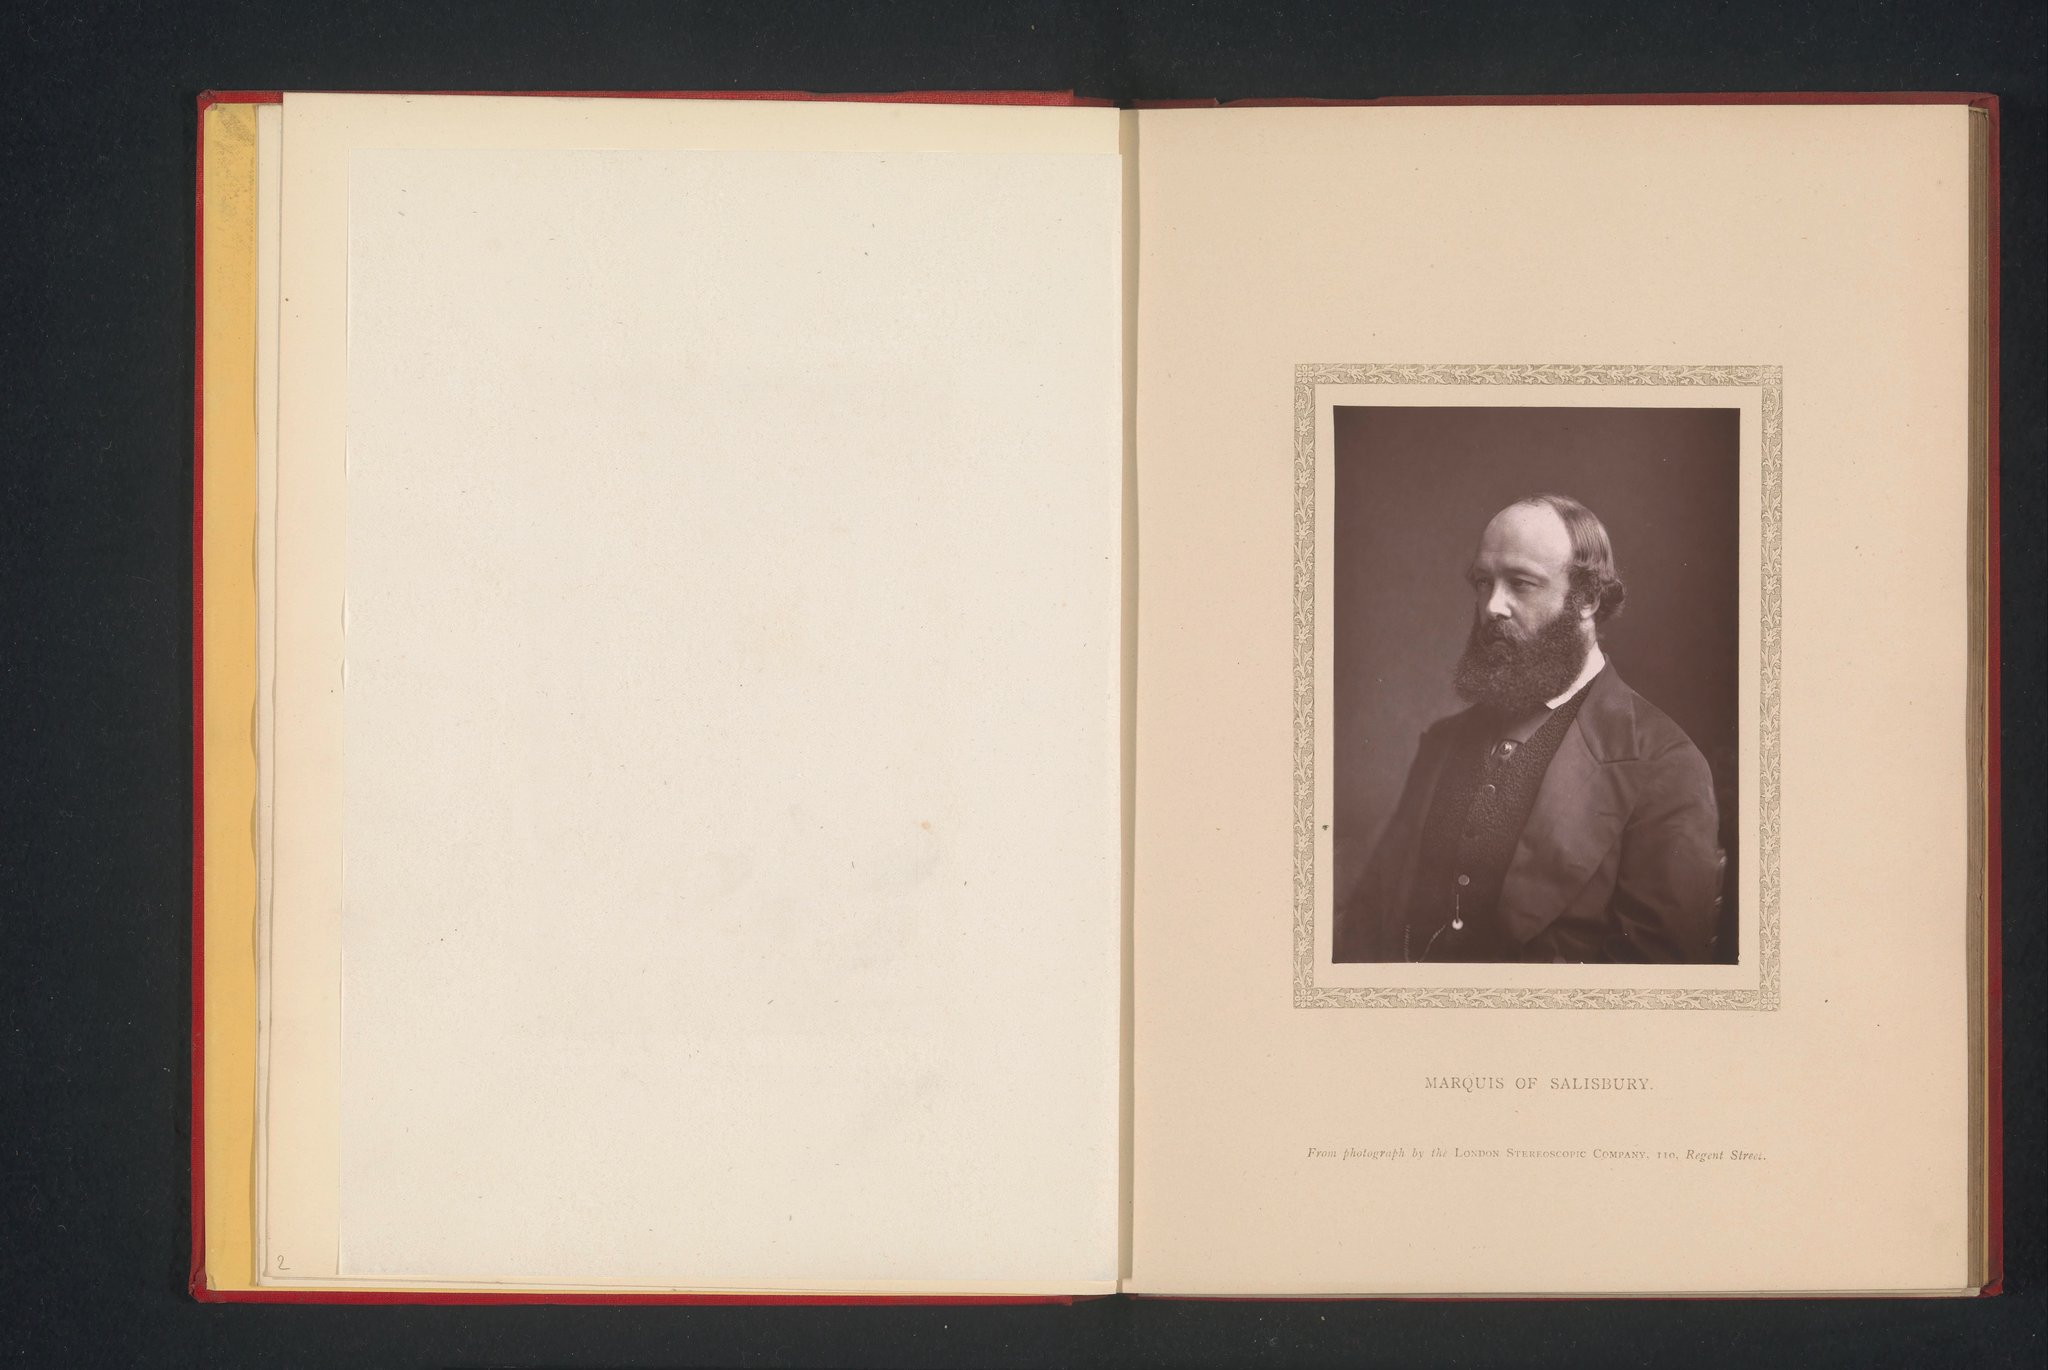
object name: photomechanical print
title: Marquis of Salisbury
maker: Anonymous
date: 1876-1881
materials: paper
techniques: woodburytype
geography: london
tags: politician, politician, e.g. party leader